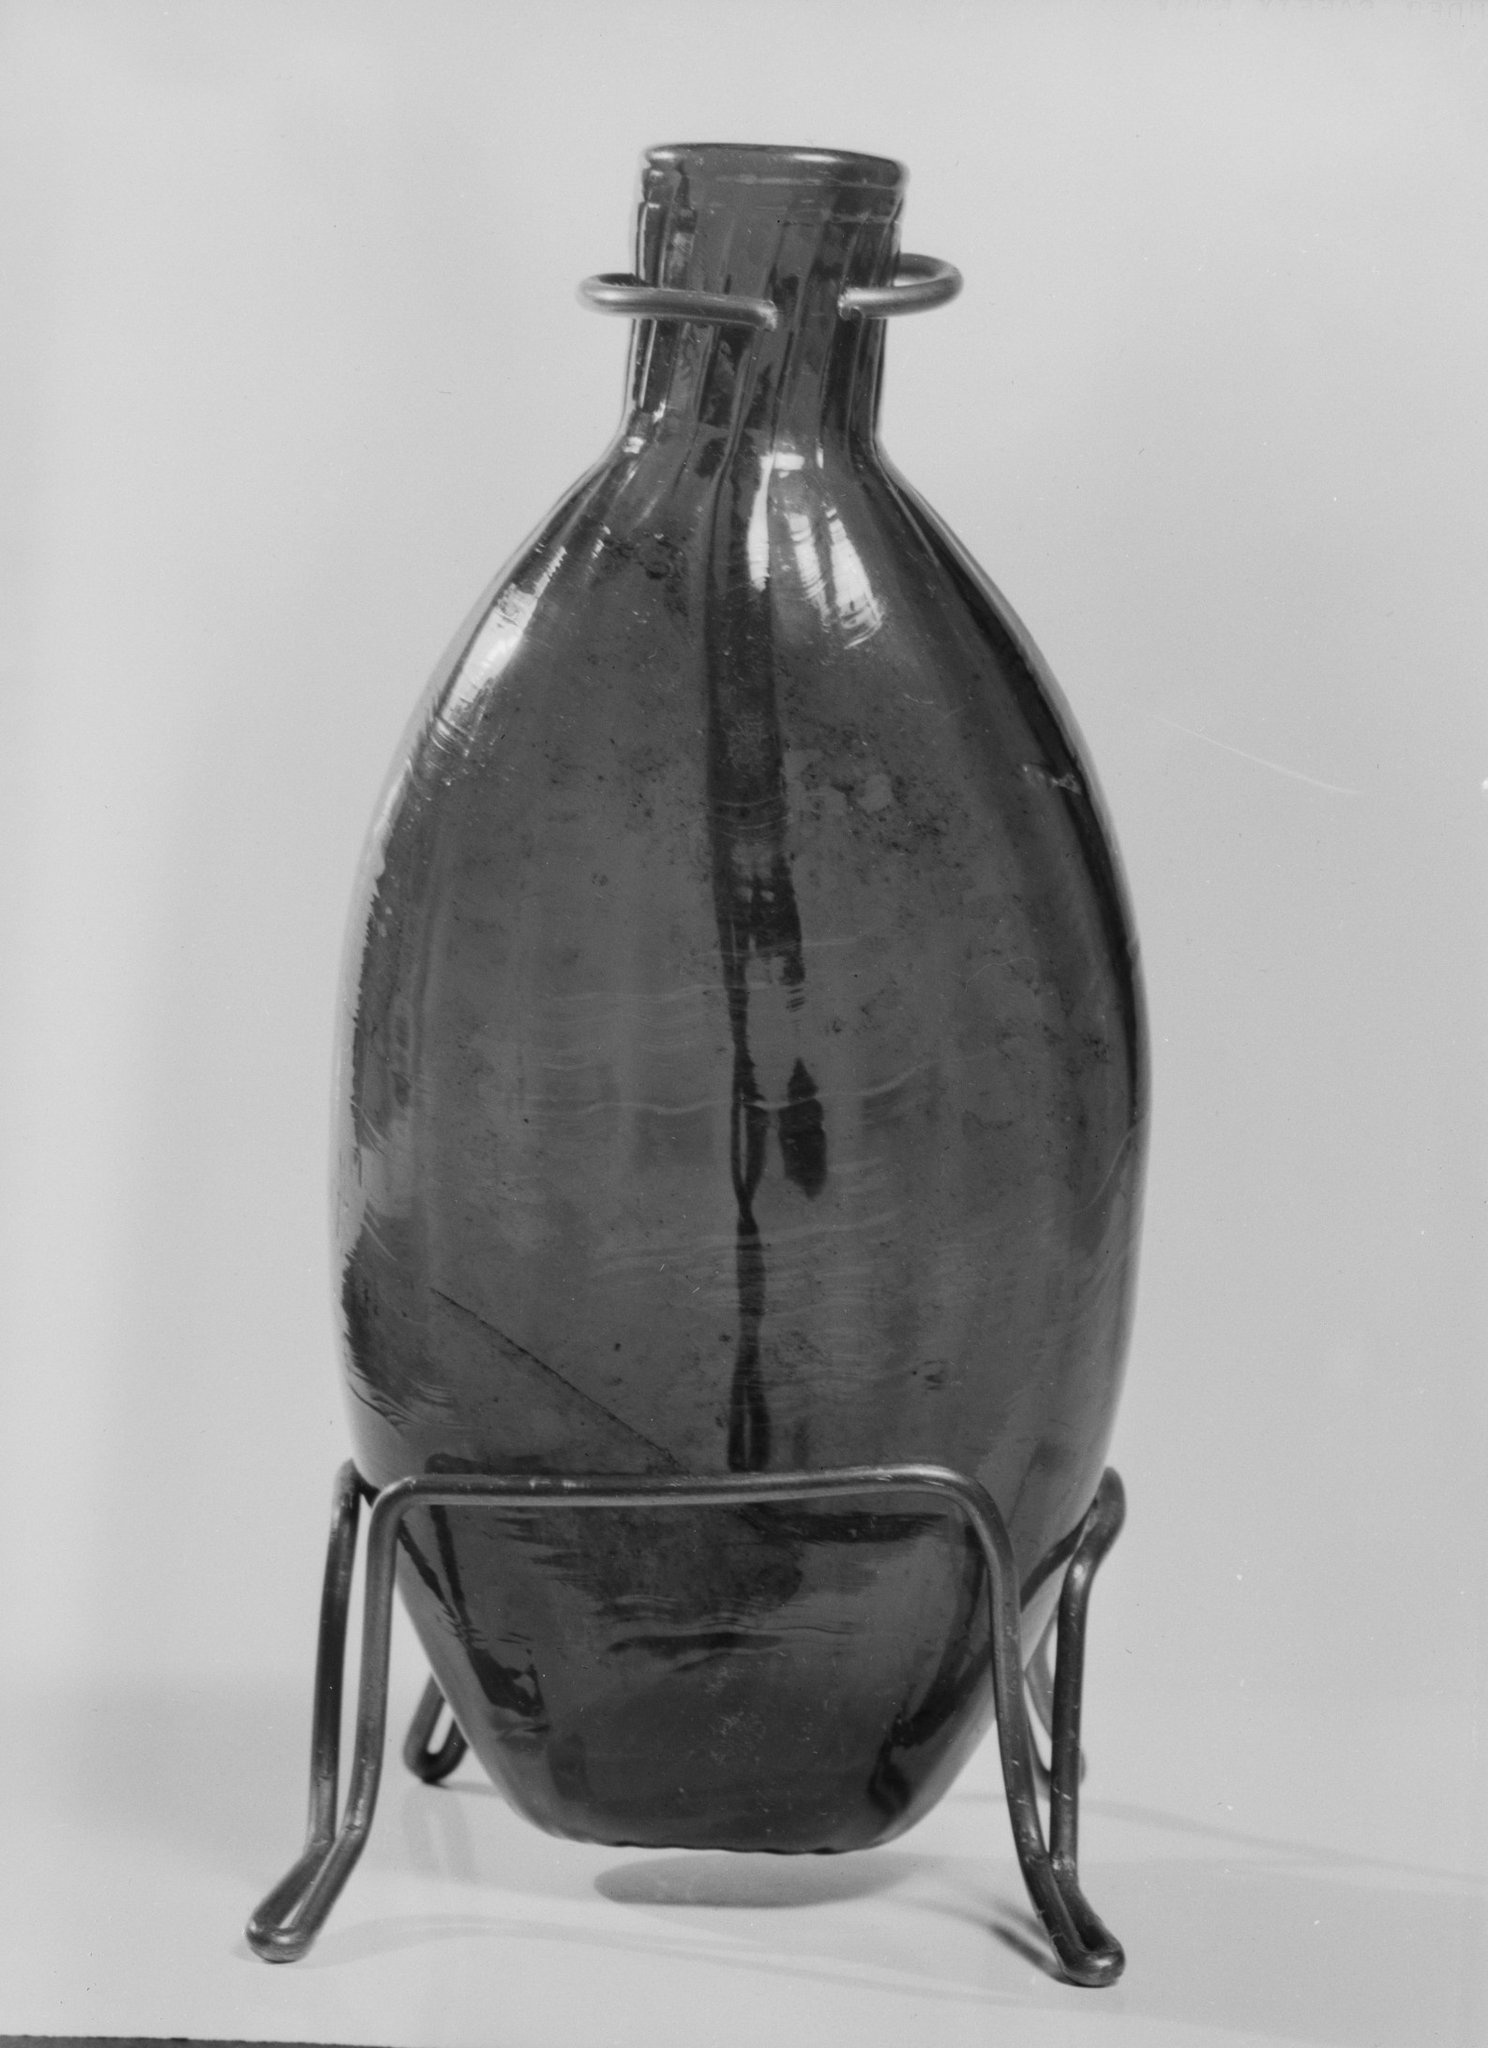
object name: flask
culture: american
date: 1800-1830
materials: glass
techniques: glassblowing, molding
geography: united states